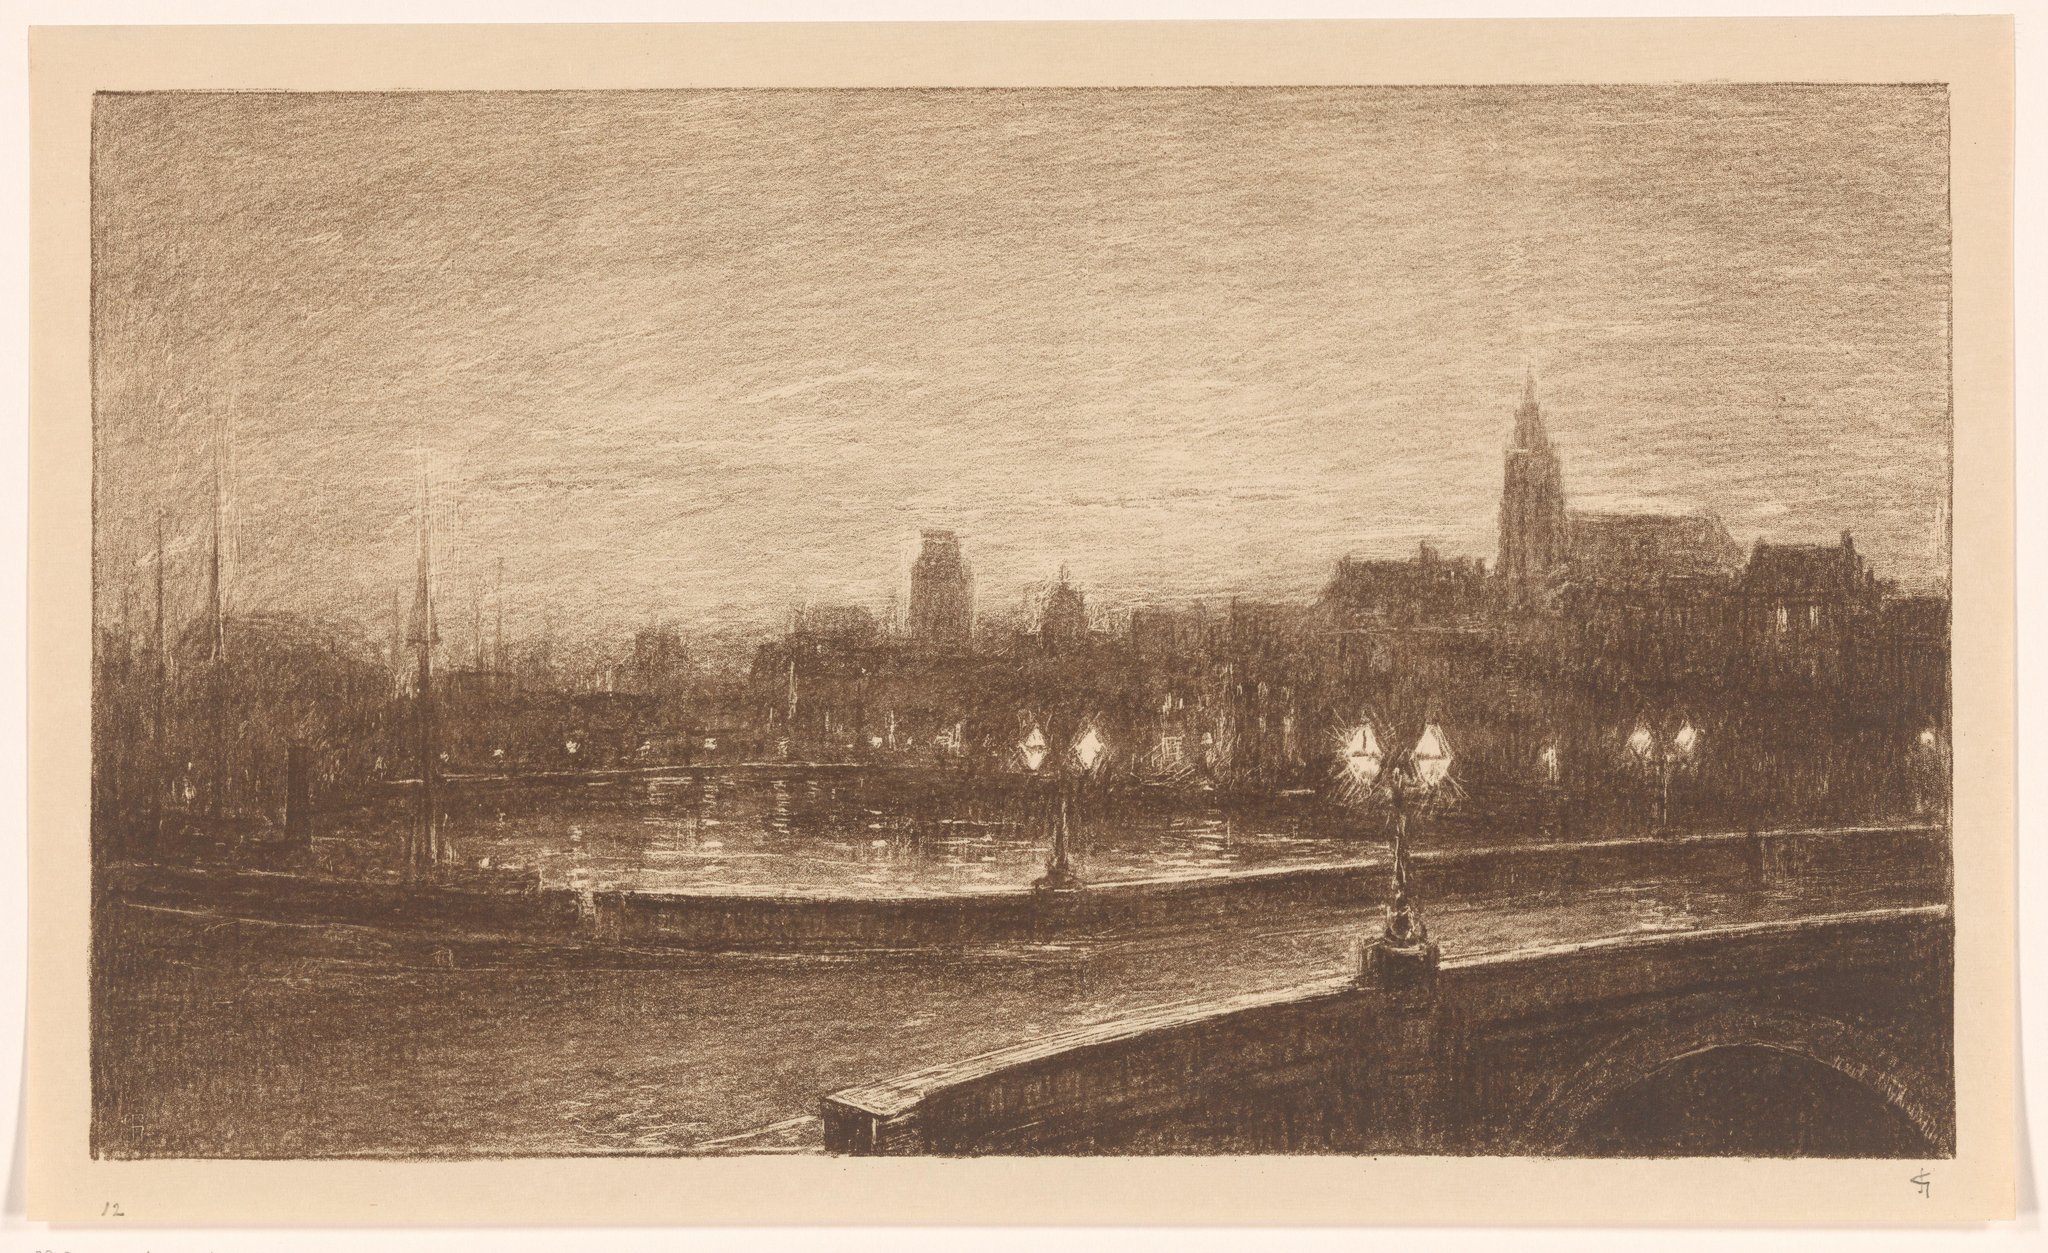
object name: print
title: Brug in Rotterdam bij nacht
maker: carel nicolaas storm van s-gravesande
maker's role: draughtsman, print maker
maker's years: 1841-1924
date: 1851-1902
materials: paper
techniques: lithograph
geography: netherlands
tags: bridge in city across river, canal, etc., night, rotterdam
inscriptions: collector's mark: Lugt 2228, number: ‘12’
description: Mogelijk vermeld in: Storm van 's-Gravesande, Charles. Catalogue des eaux-fortes et lithographies. New York: s.n., 1903, of in een onbekende latere uitgave van het manuscript. Vermoedelijk vermeld als catalogusnummer 12.